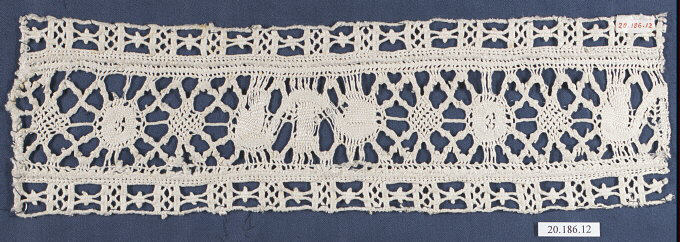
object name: insertion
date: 1501-1600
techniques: lace